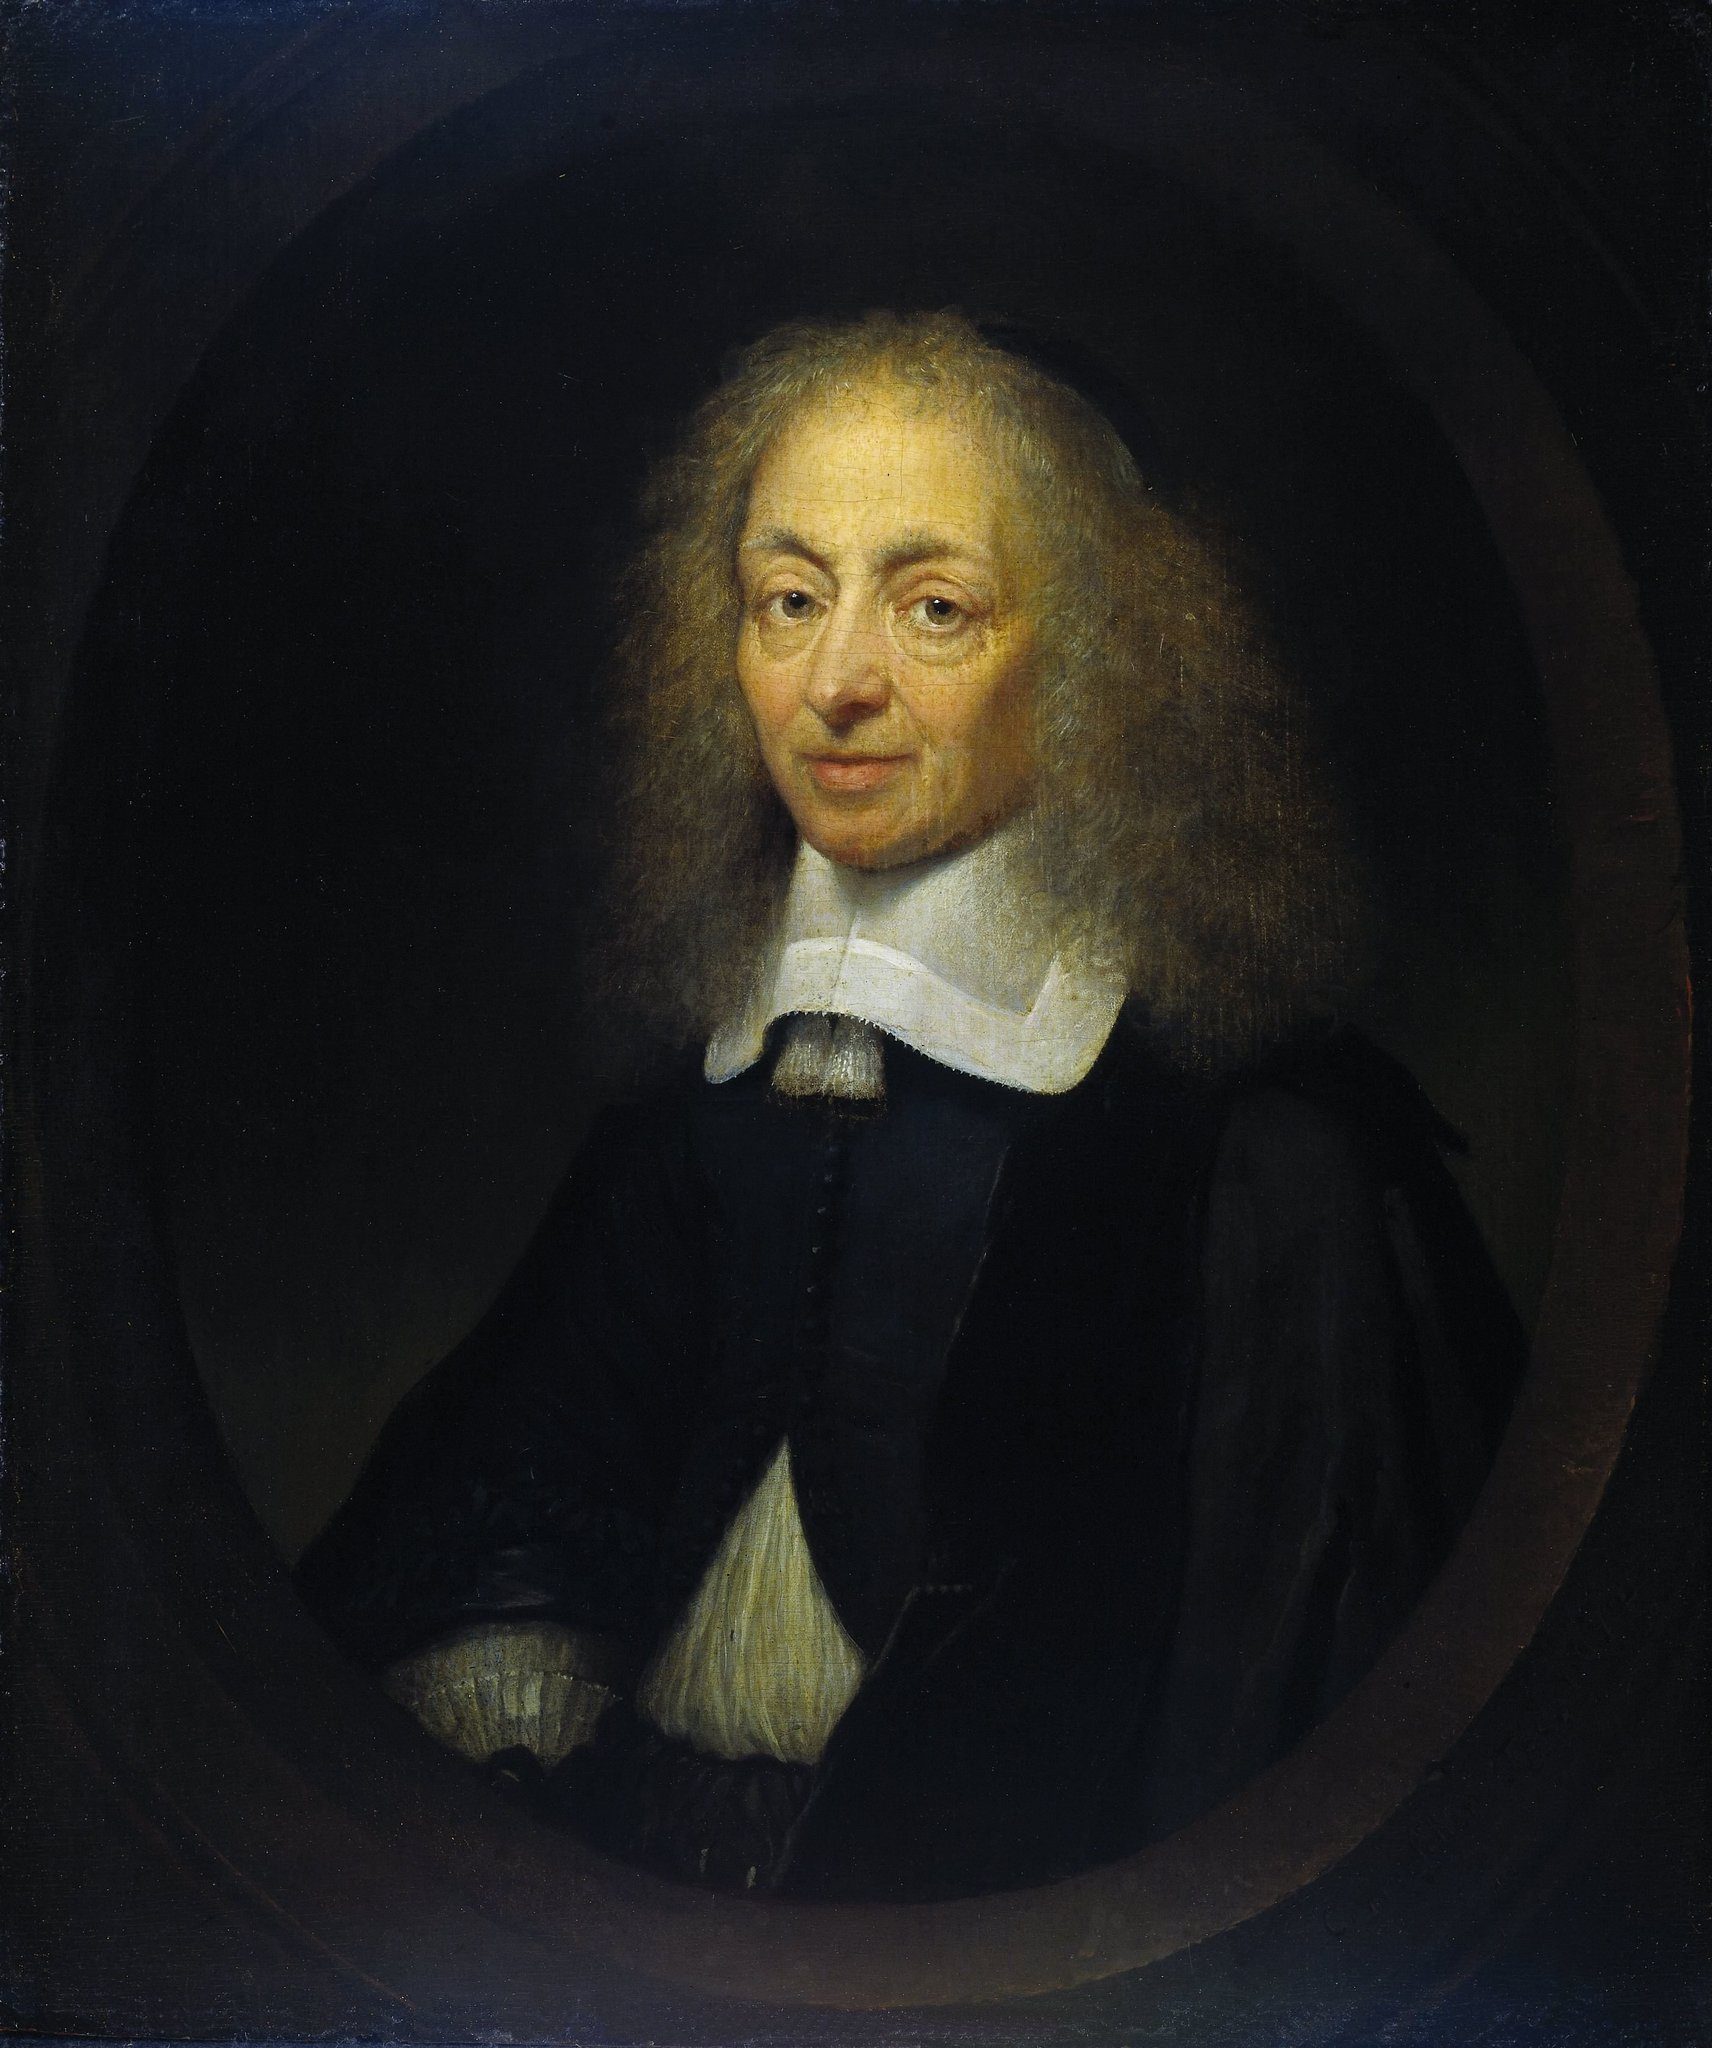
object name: painting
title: Portrait of Constantijn Huygens (1596-1687)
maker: caspar netscher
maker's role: draughtsman, painter, print maker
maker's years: 1639-1684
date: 1672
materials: oil, panel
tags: constantijn huygens (i), historical persons, writer, poet, author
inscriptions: signature and date: ‘C. Netscher Fec 1672’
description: Portret van Constantijn Huygens, heer van Zuylichem. Secretaris van Frederik Hendrik, Willem II en Willem III, en dichter. Buste in ovaal, naar links.